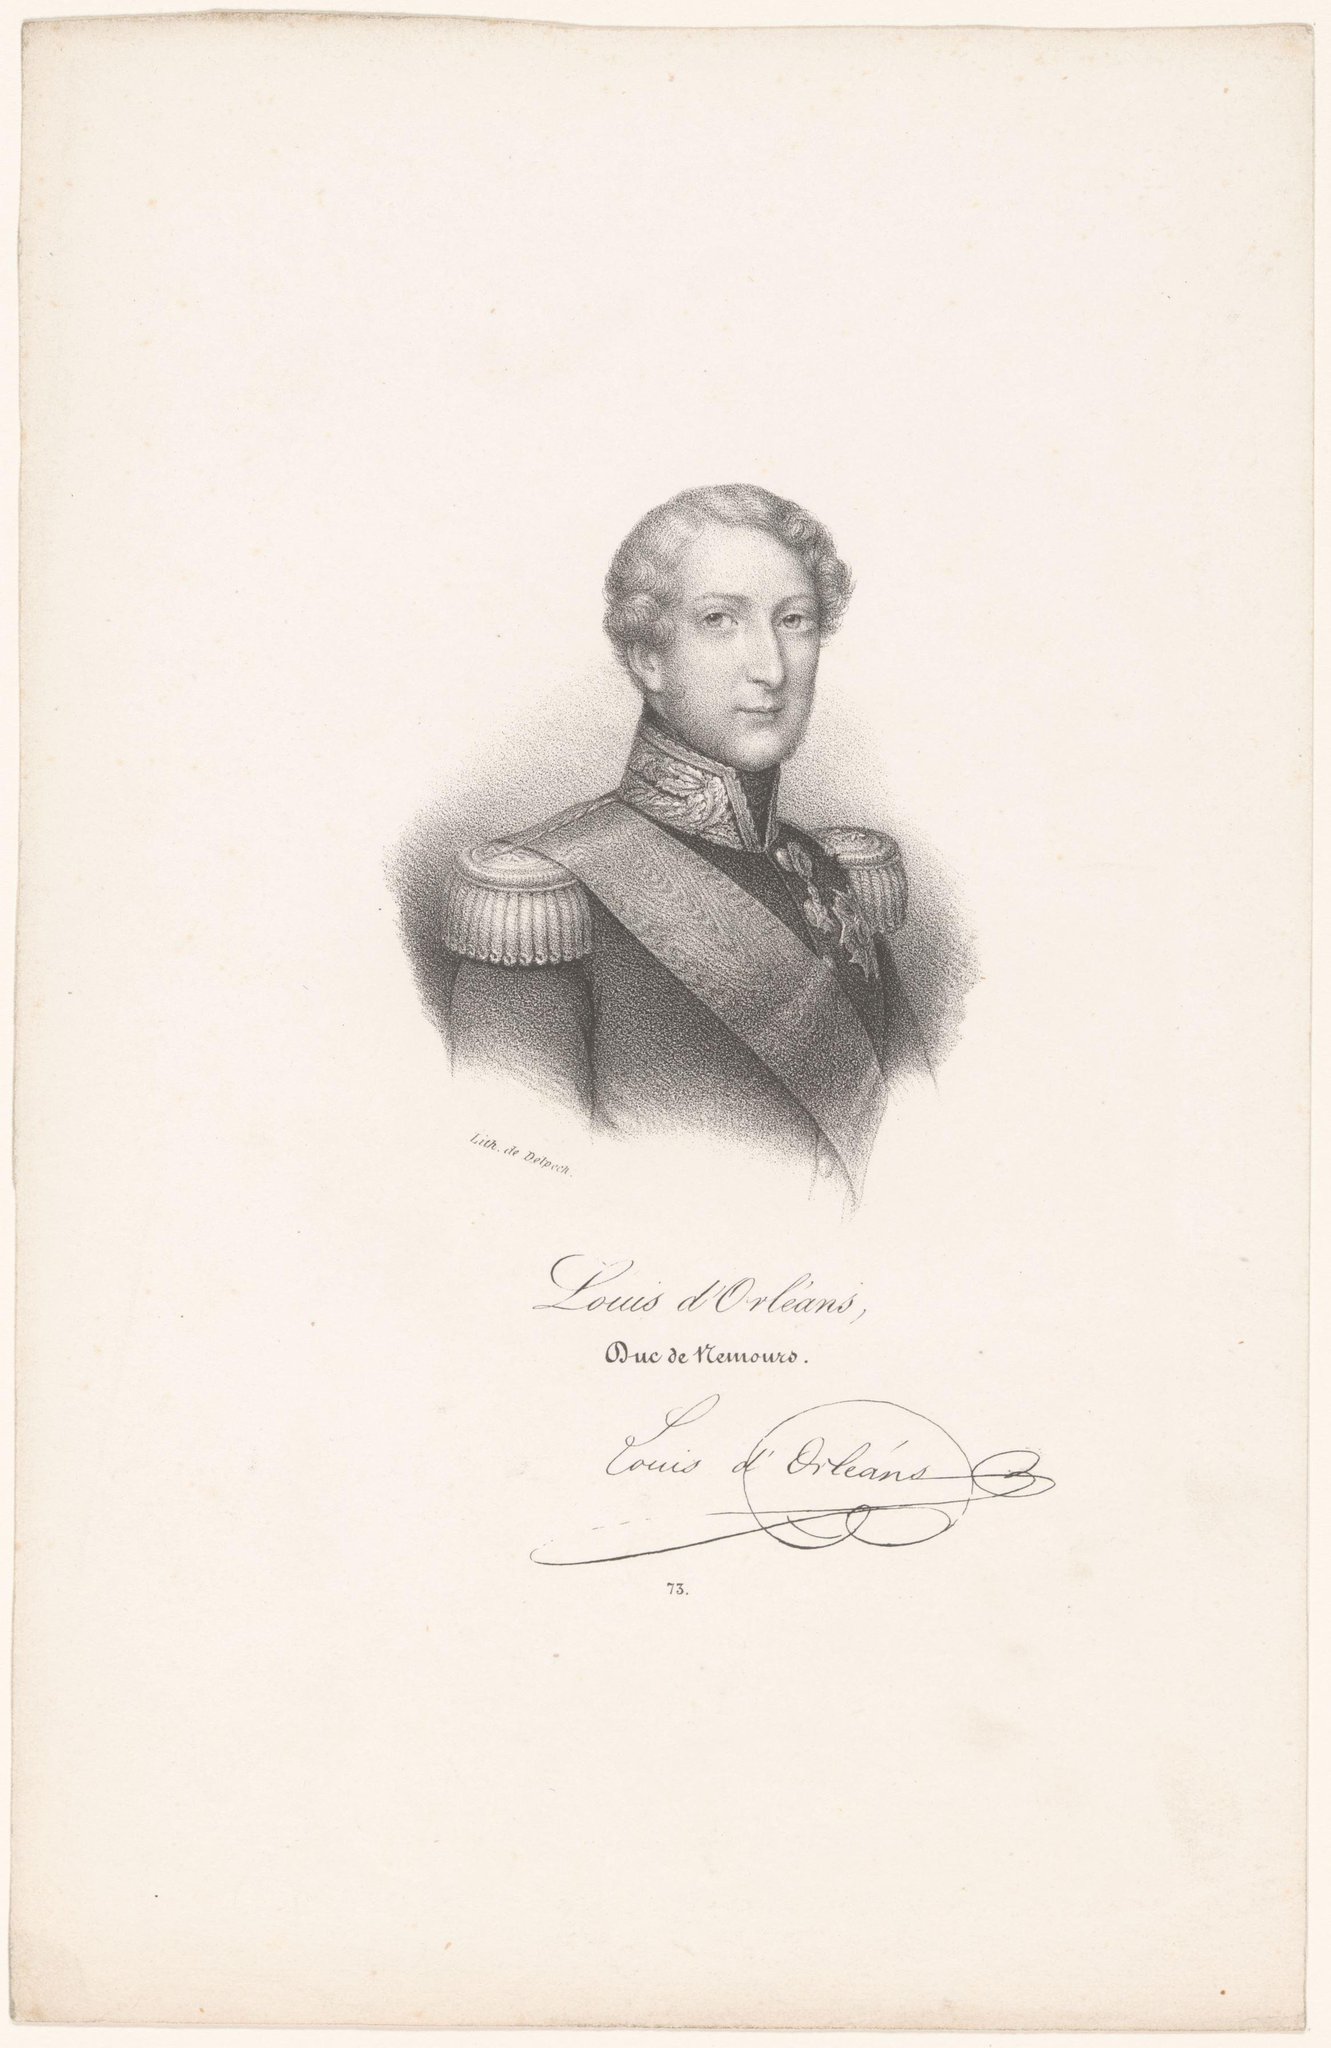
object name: print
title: Portret van Lodewijk van Orléans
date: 1839-1842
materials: paper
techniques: lithograph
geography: paris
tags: paris, historical persons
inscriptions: collector's mark: Lugt 2228a